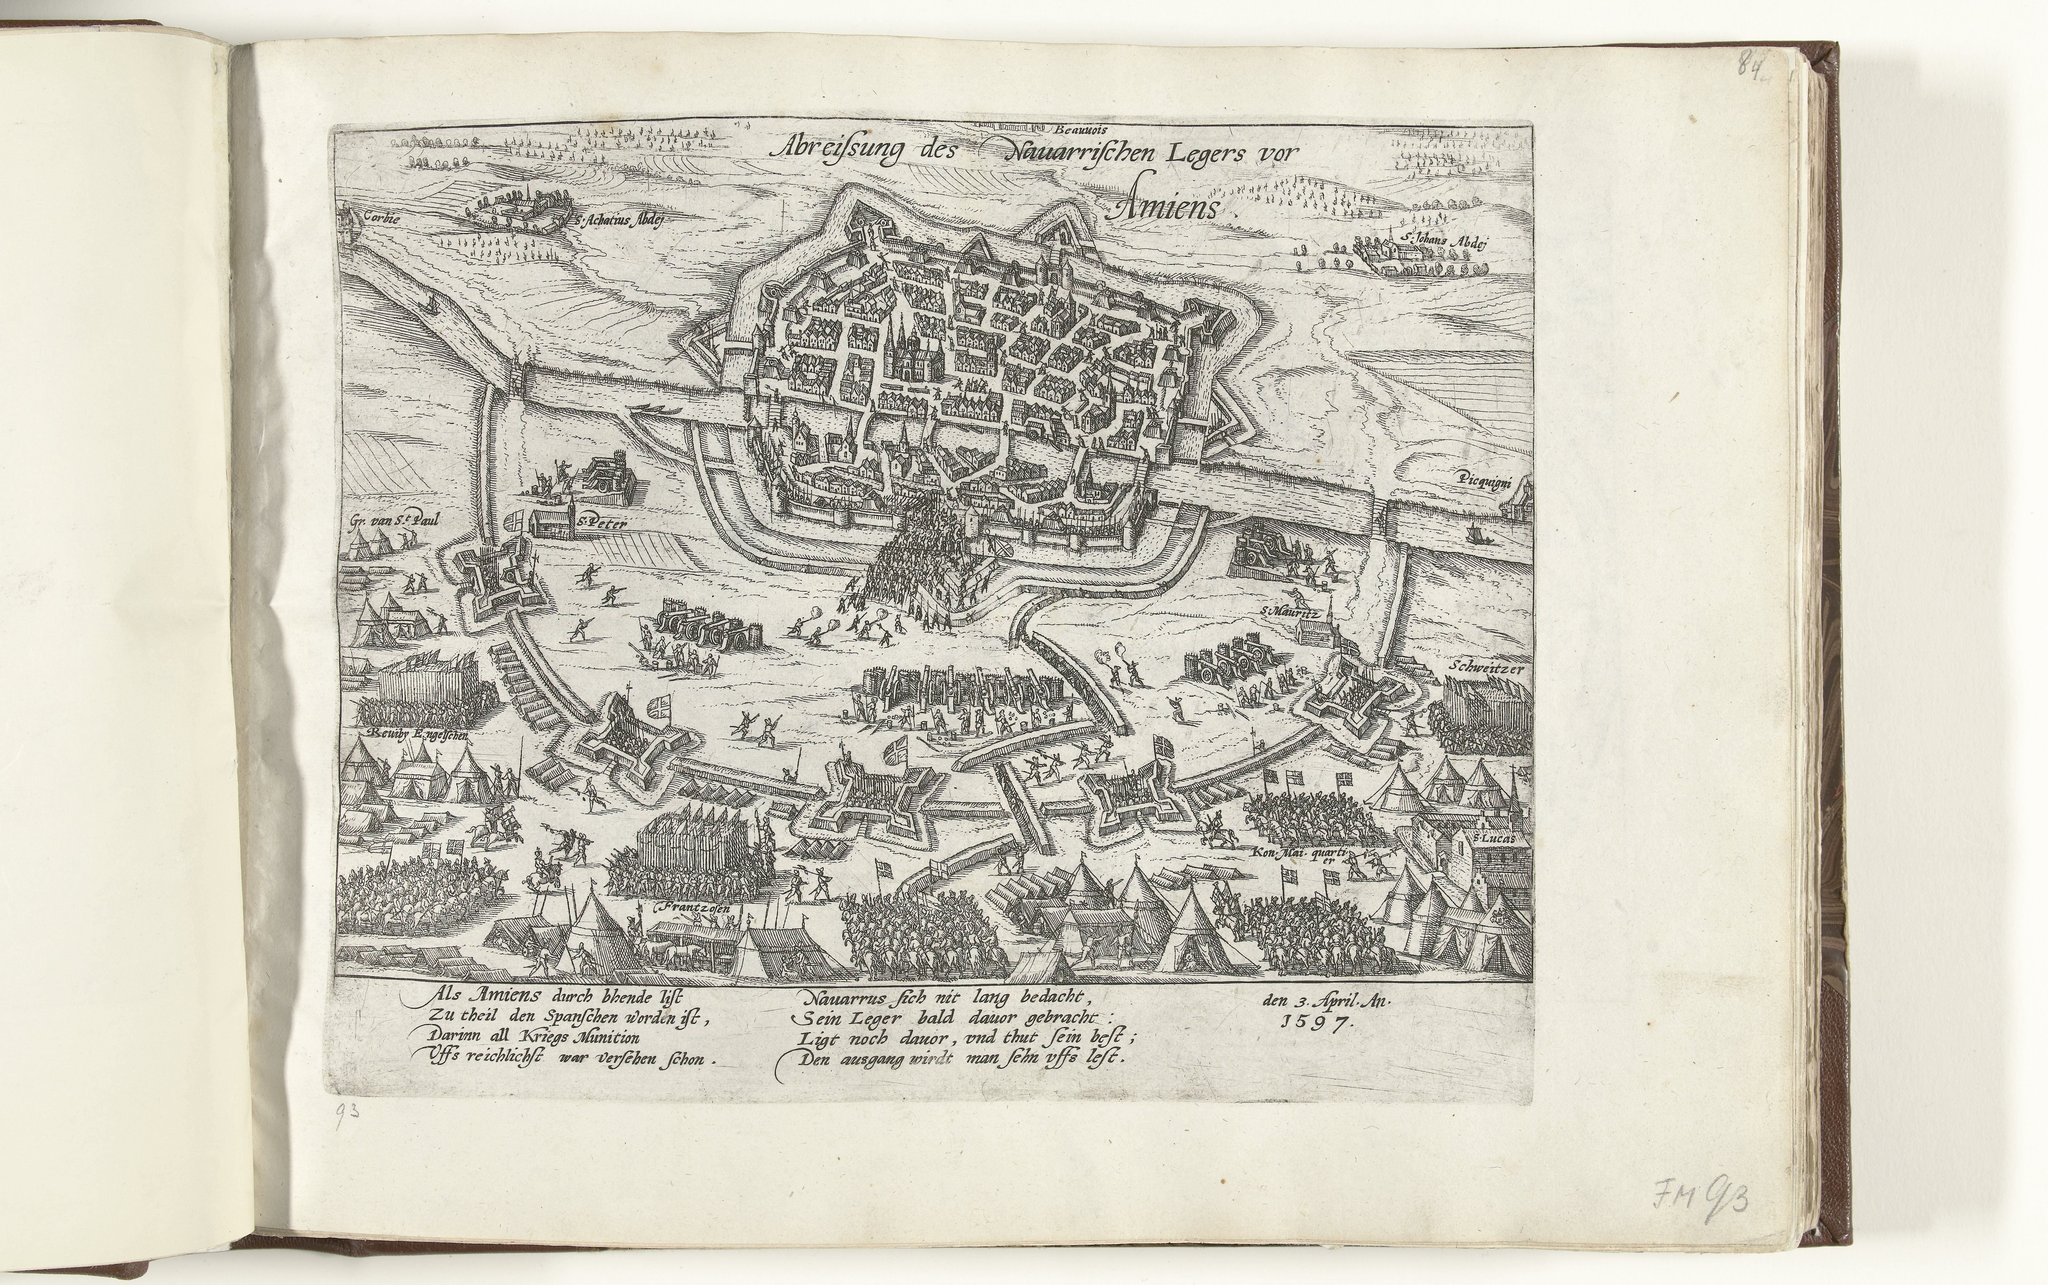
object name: print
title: Abreissung des Navarrischen Legers vor Amiens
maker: frans hogenberg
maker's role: print maker, publisher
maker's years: 1538-1590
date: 1597-1612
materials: paper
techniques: etching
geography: cologne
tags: paris, hendrik iv (koning van frankrijk en navarra), siege, position war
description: Beleg van Amiens door het leger van koning Hendrik IV, 3 april 1597. Gezicht op de stellingen van de belegeraars, boven de ommuurde stad. Met onderschrift van 8 regels in het Duits. Ongenummerd.